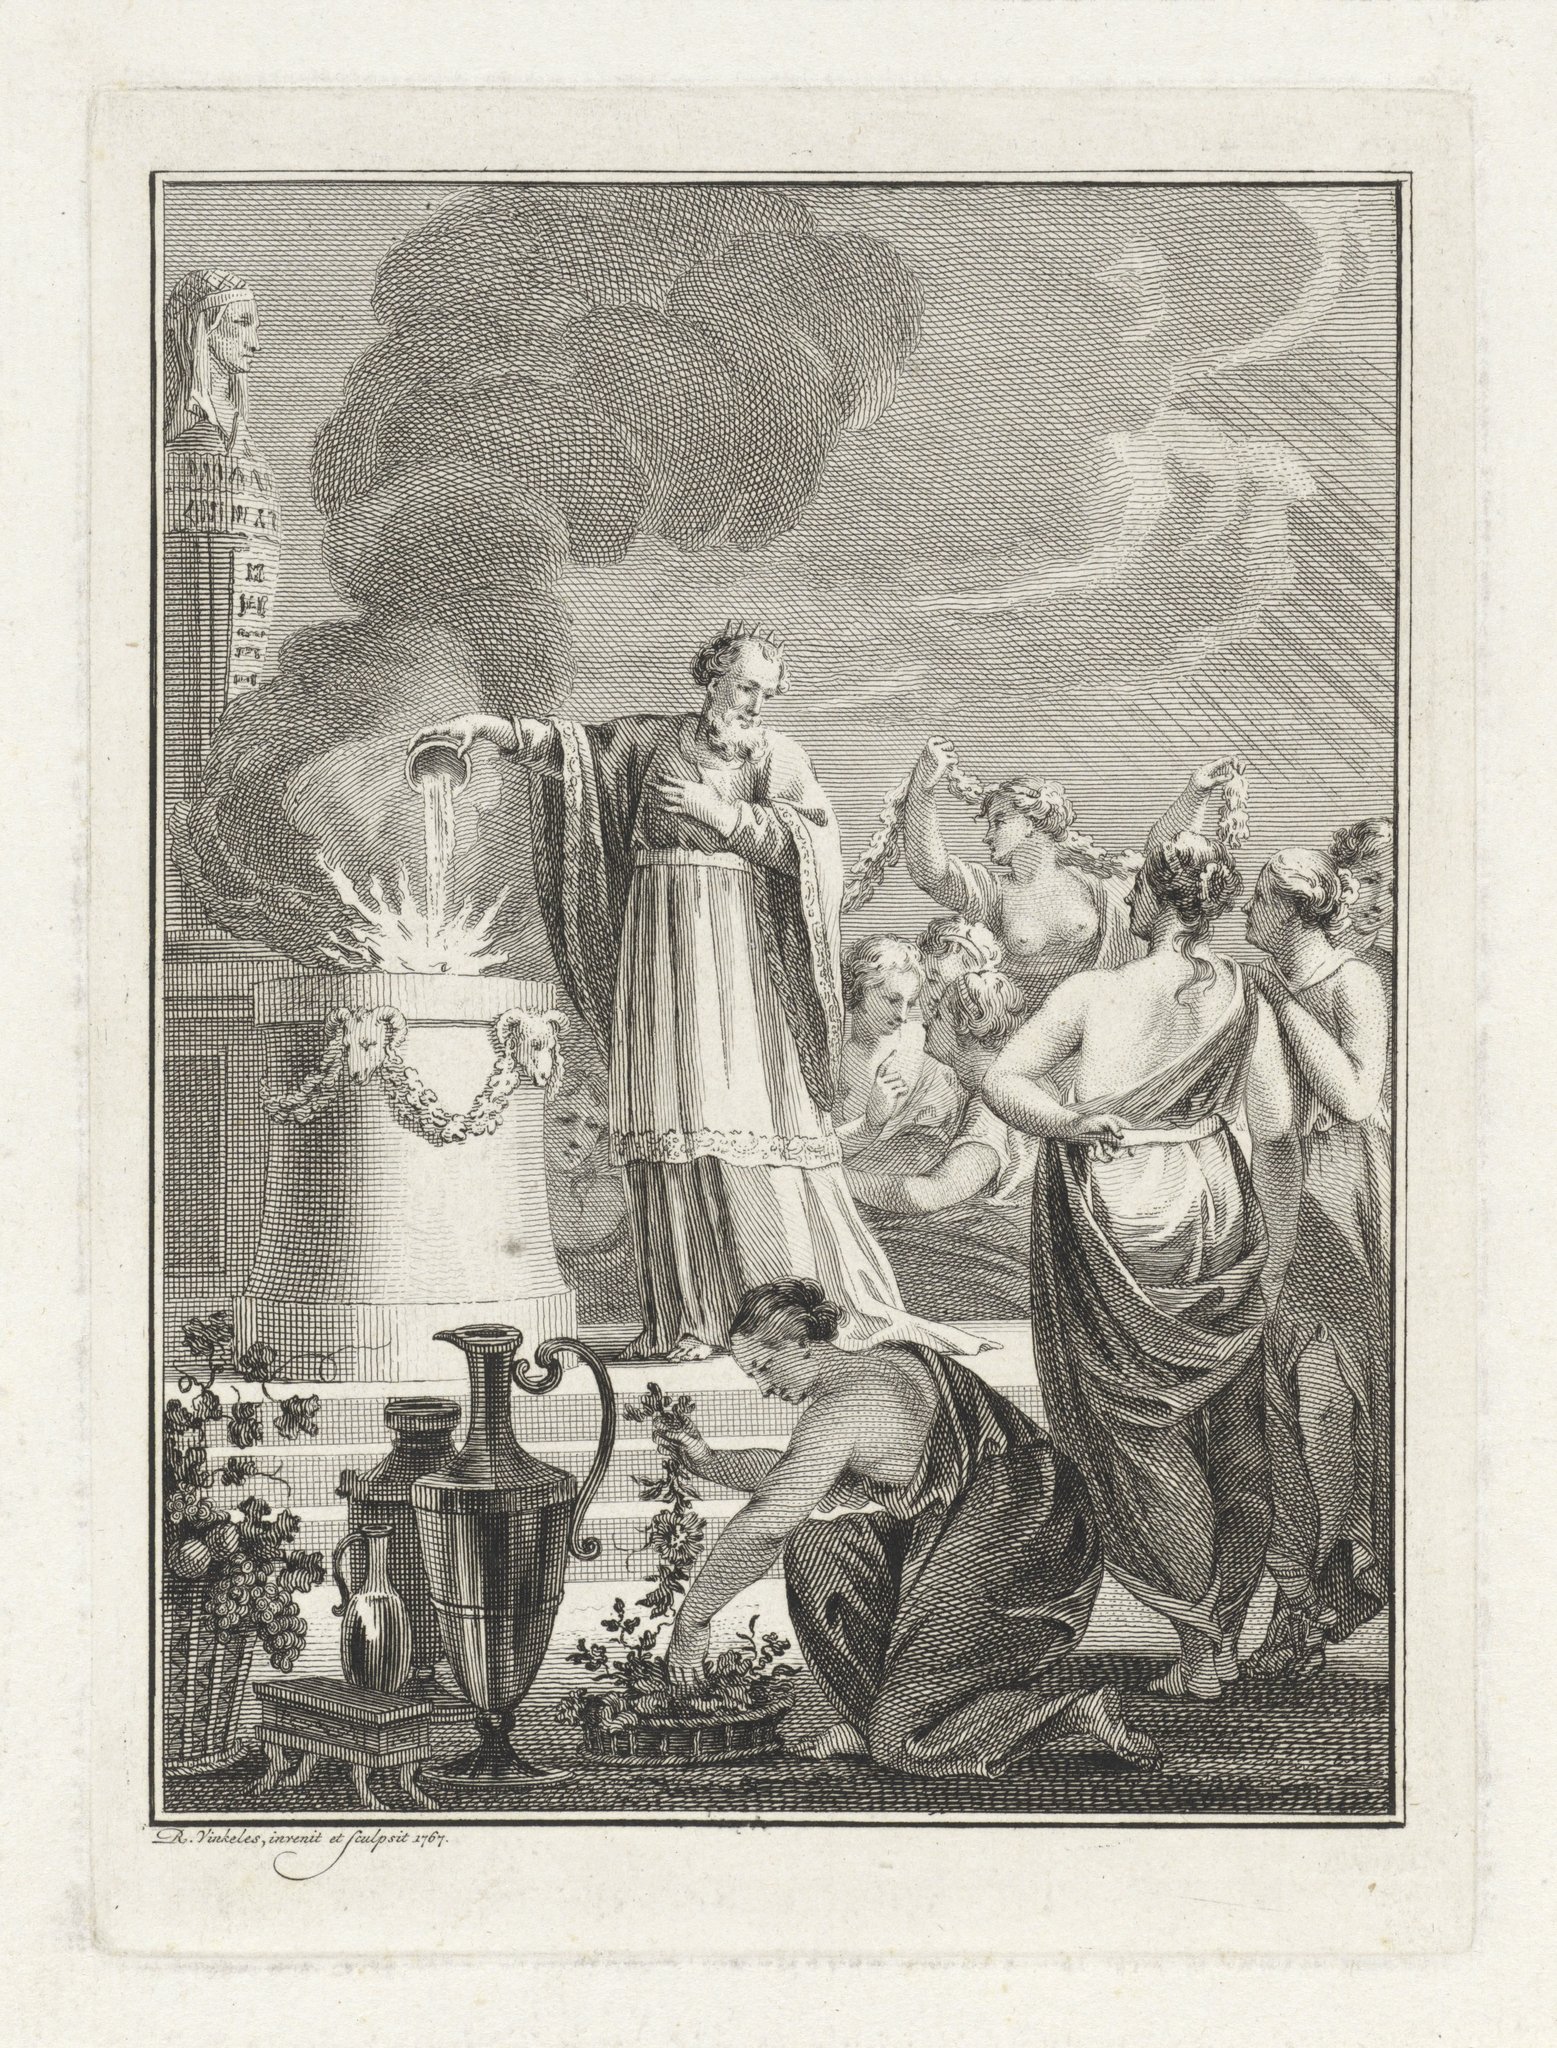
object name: print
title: Afgoderij van Salomo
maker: reinier vinkeles (i)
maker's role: draughtsman, print maker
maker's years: 1741-1816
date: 1767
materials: paper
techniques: engraving, etching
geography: amsterdam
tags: solomon's idolatry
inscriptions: collector's mark: Lugt 240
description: Salomo brengt een offer aan een afgodsbeeld dat op een sokkel staat. Om hem heen zijn vrouwen die hem tot afgoderij hebben verleid. (1. Kon. 11:8).